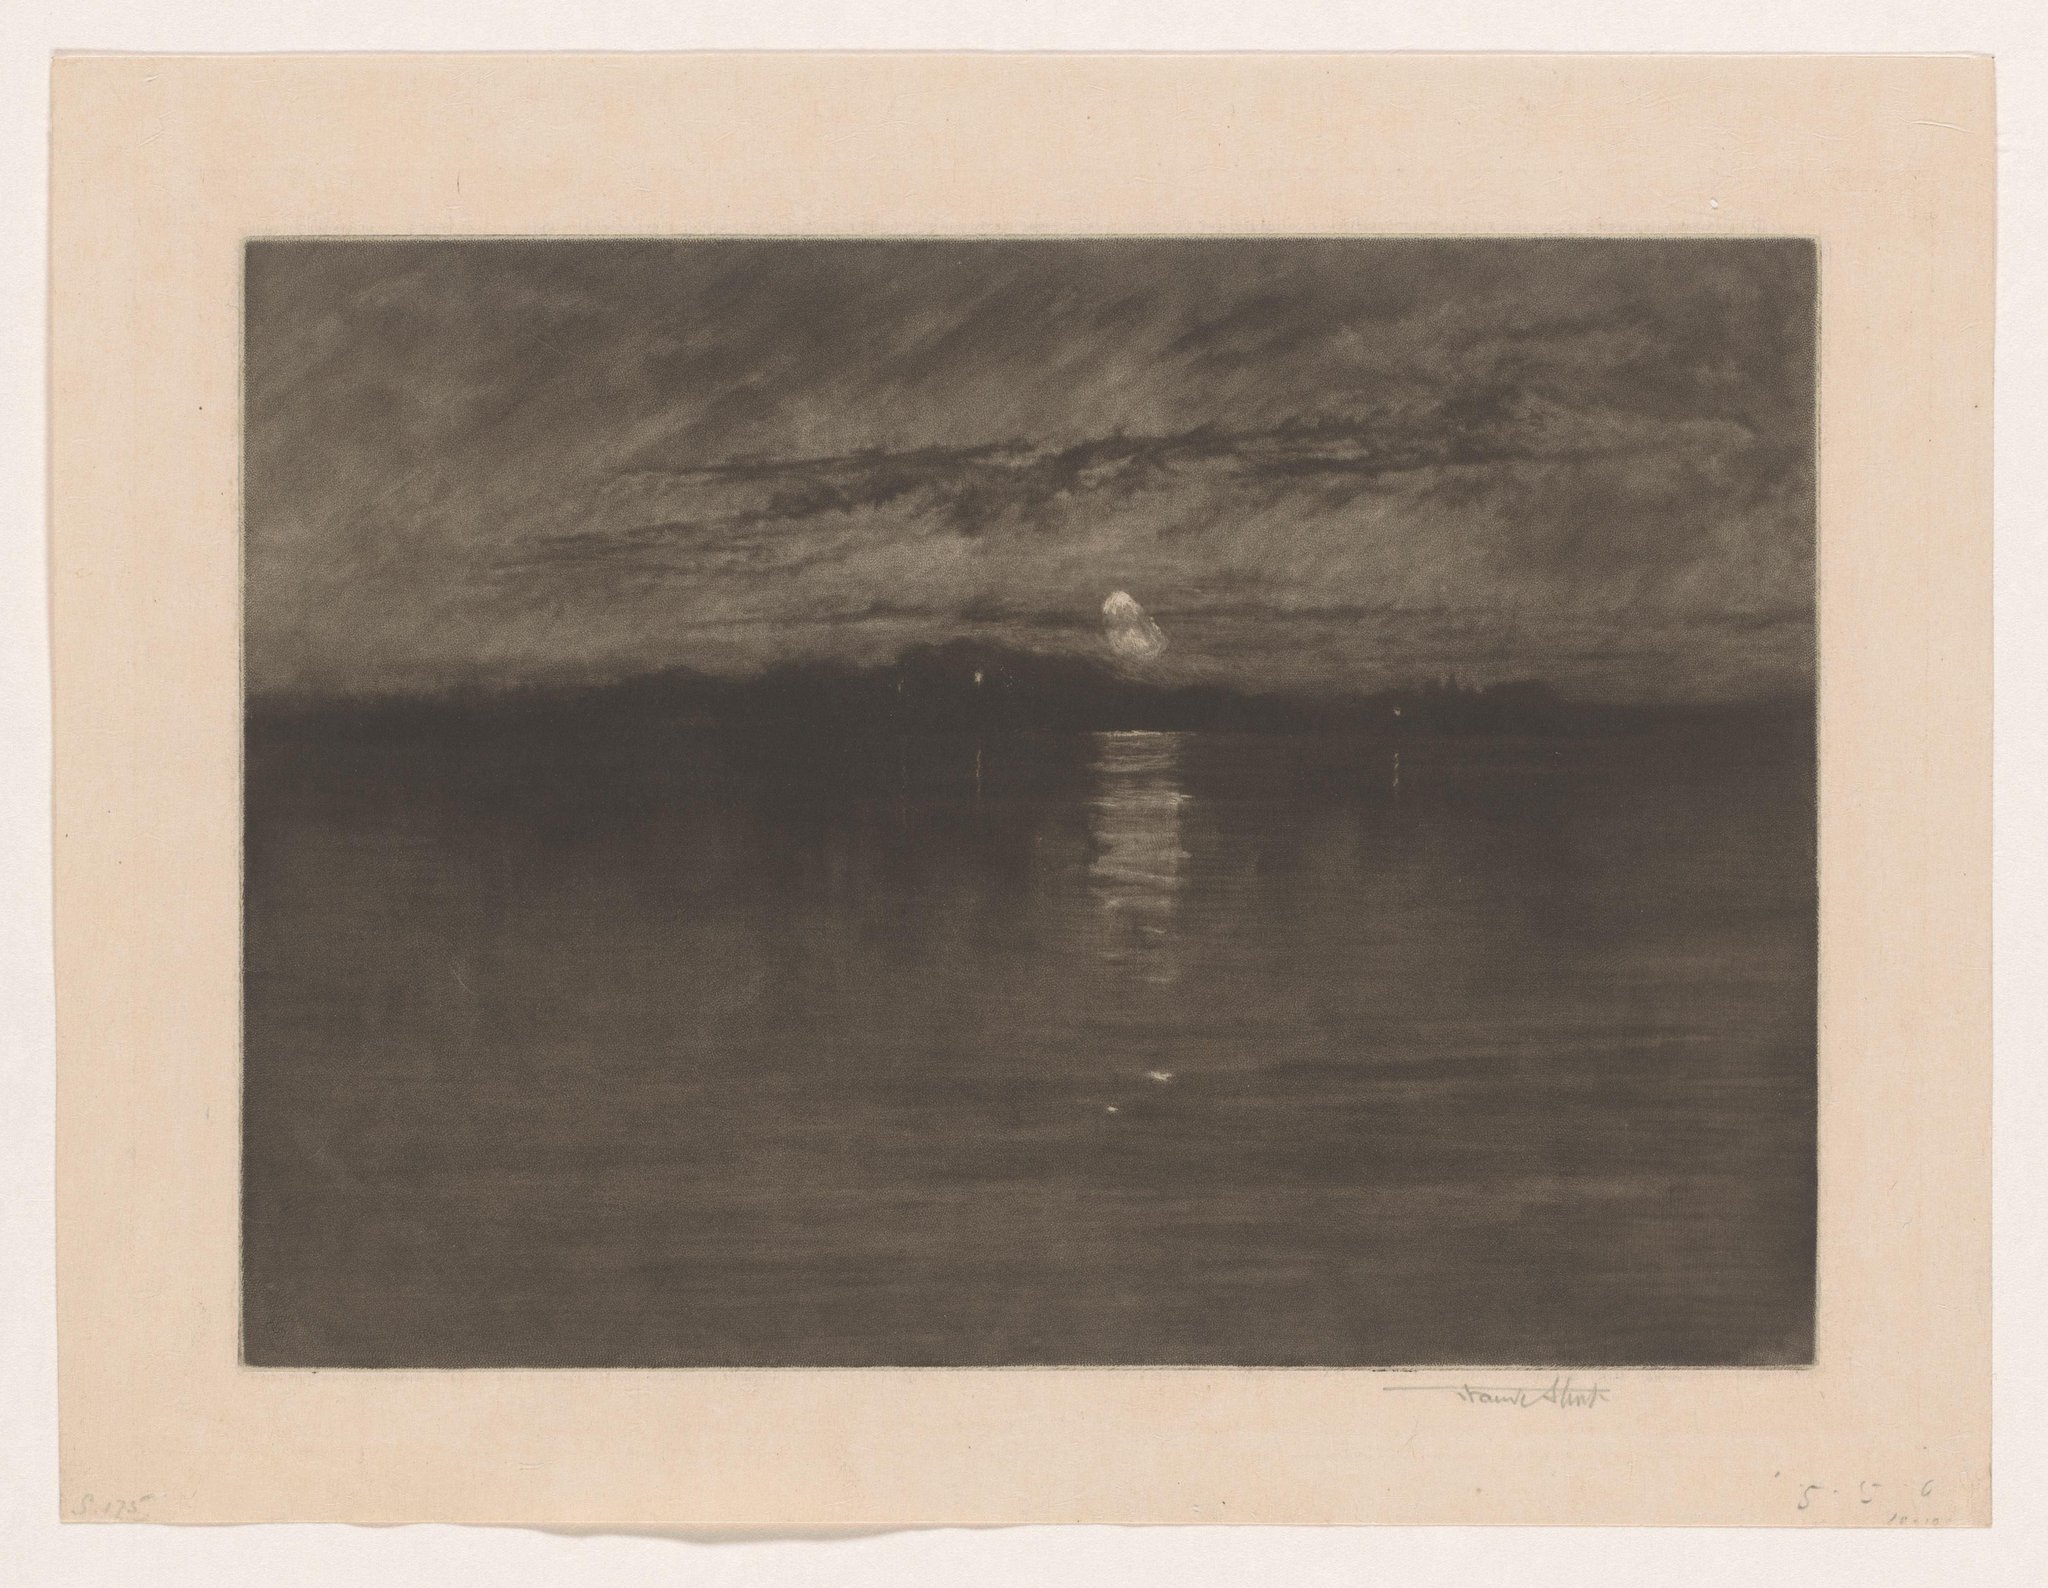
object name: print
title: When the weary moon was in the wane, Dort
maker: frank short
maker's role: print maker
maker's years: 1857-1945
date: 1894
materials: paper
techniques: mezzotint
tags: night ~ landscape (sometimes titled 'nox'), lake (+ landscape with figures, staffage)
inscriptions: collector's mark: Lugt 2760, collector's mark: Lugt 2228